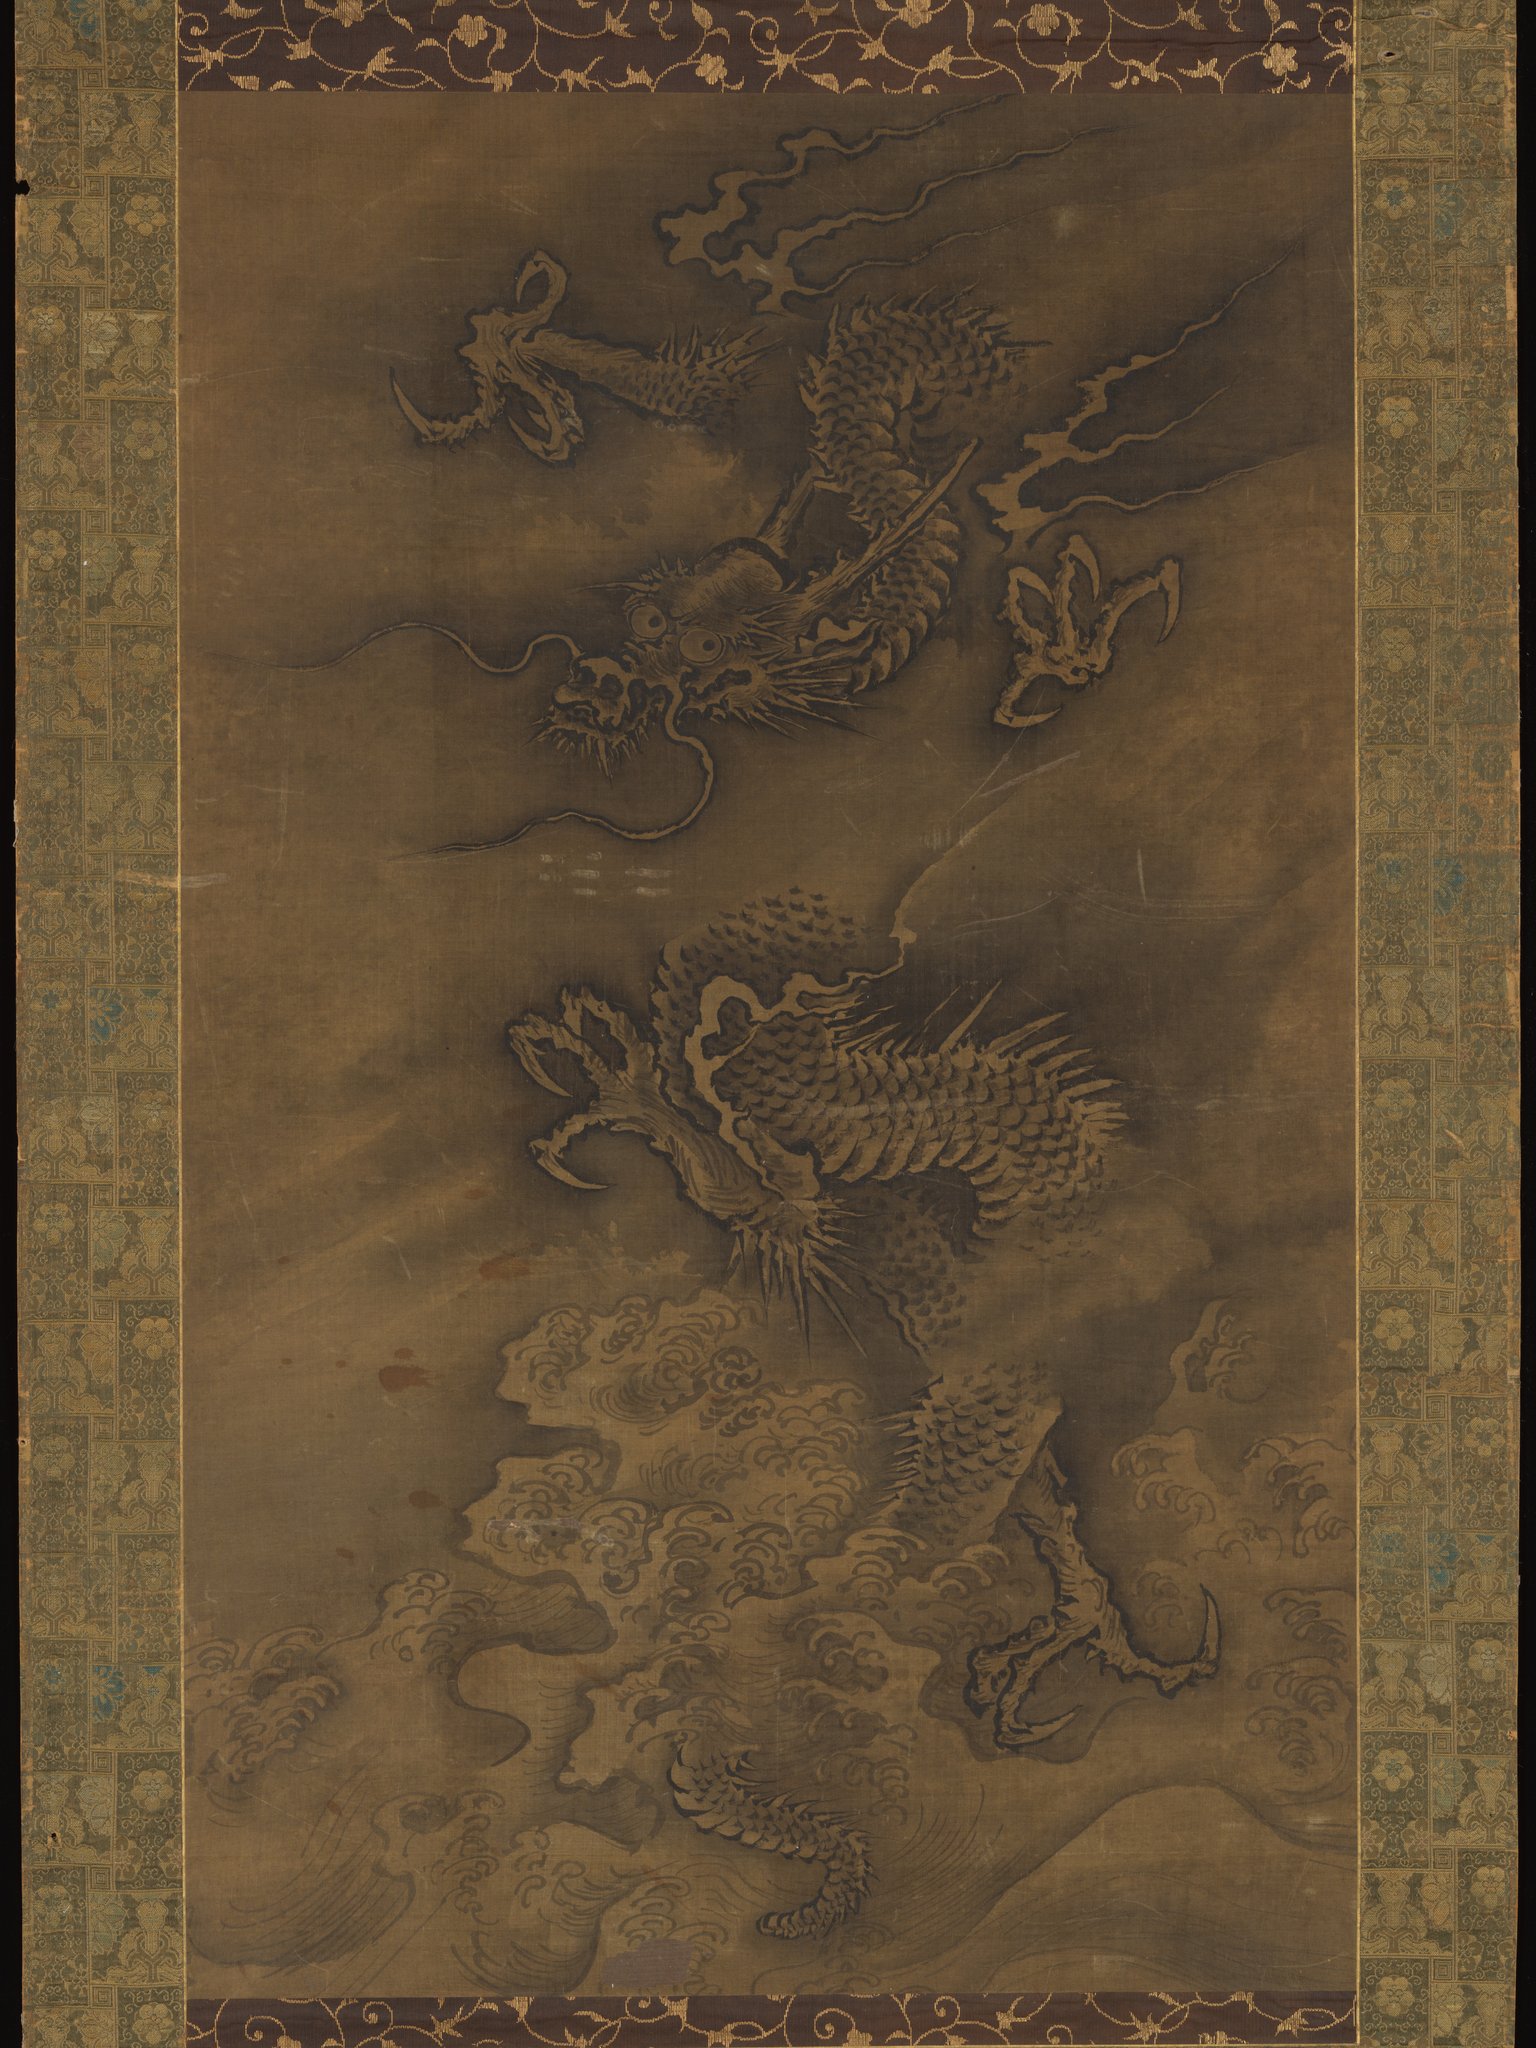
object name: hanging scroll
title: Dragon Amid Clouds and Waves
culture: chinese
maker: unidentified artist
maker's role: artist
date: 1401-1600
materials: ink, silk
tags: dragons